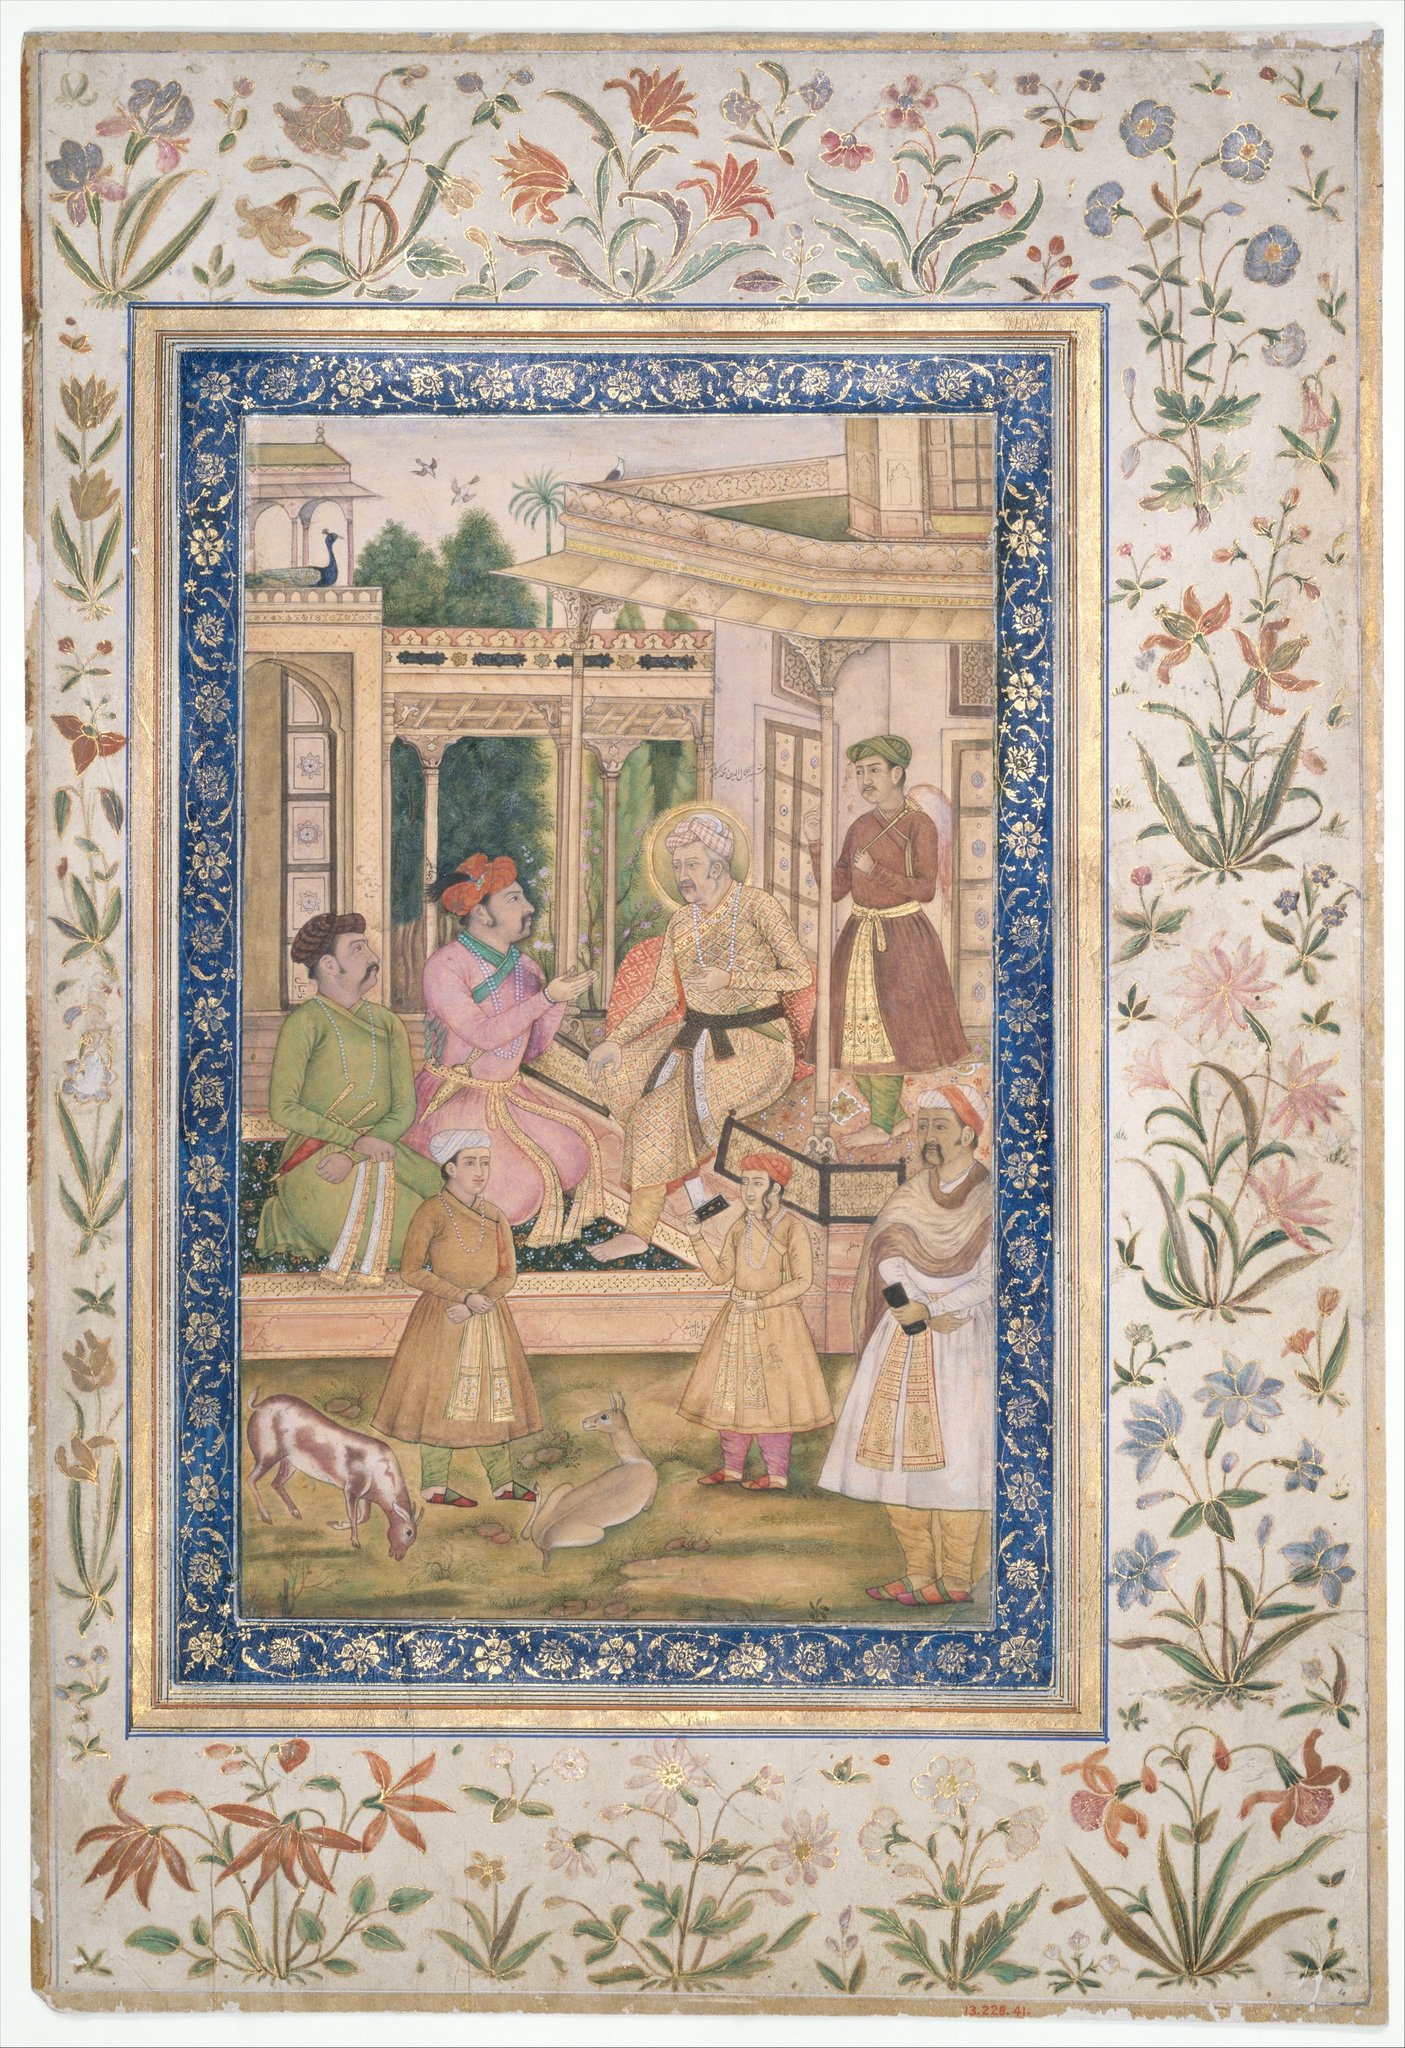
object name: album leaf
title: Akbar Visited by Jahangir and Daniyal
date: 1801-1900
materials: paper, watercolor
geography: india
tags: animals,kings,men,flowers